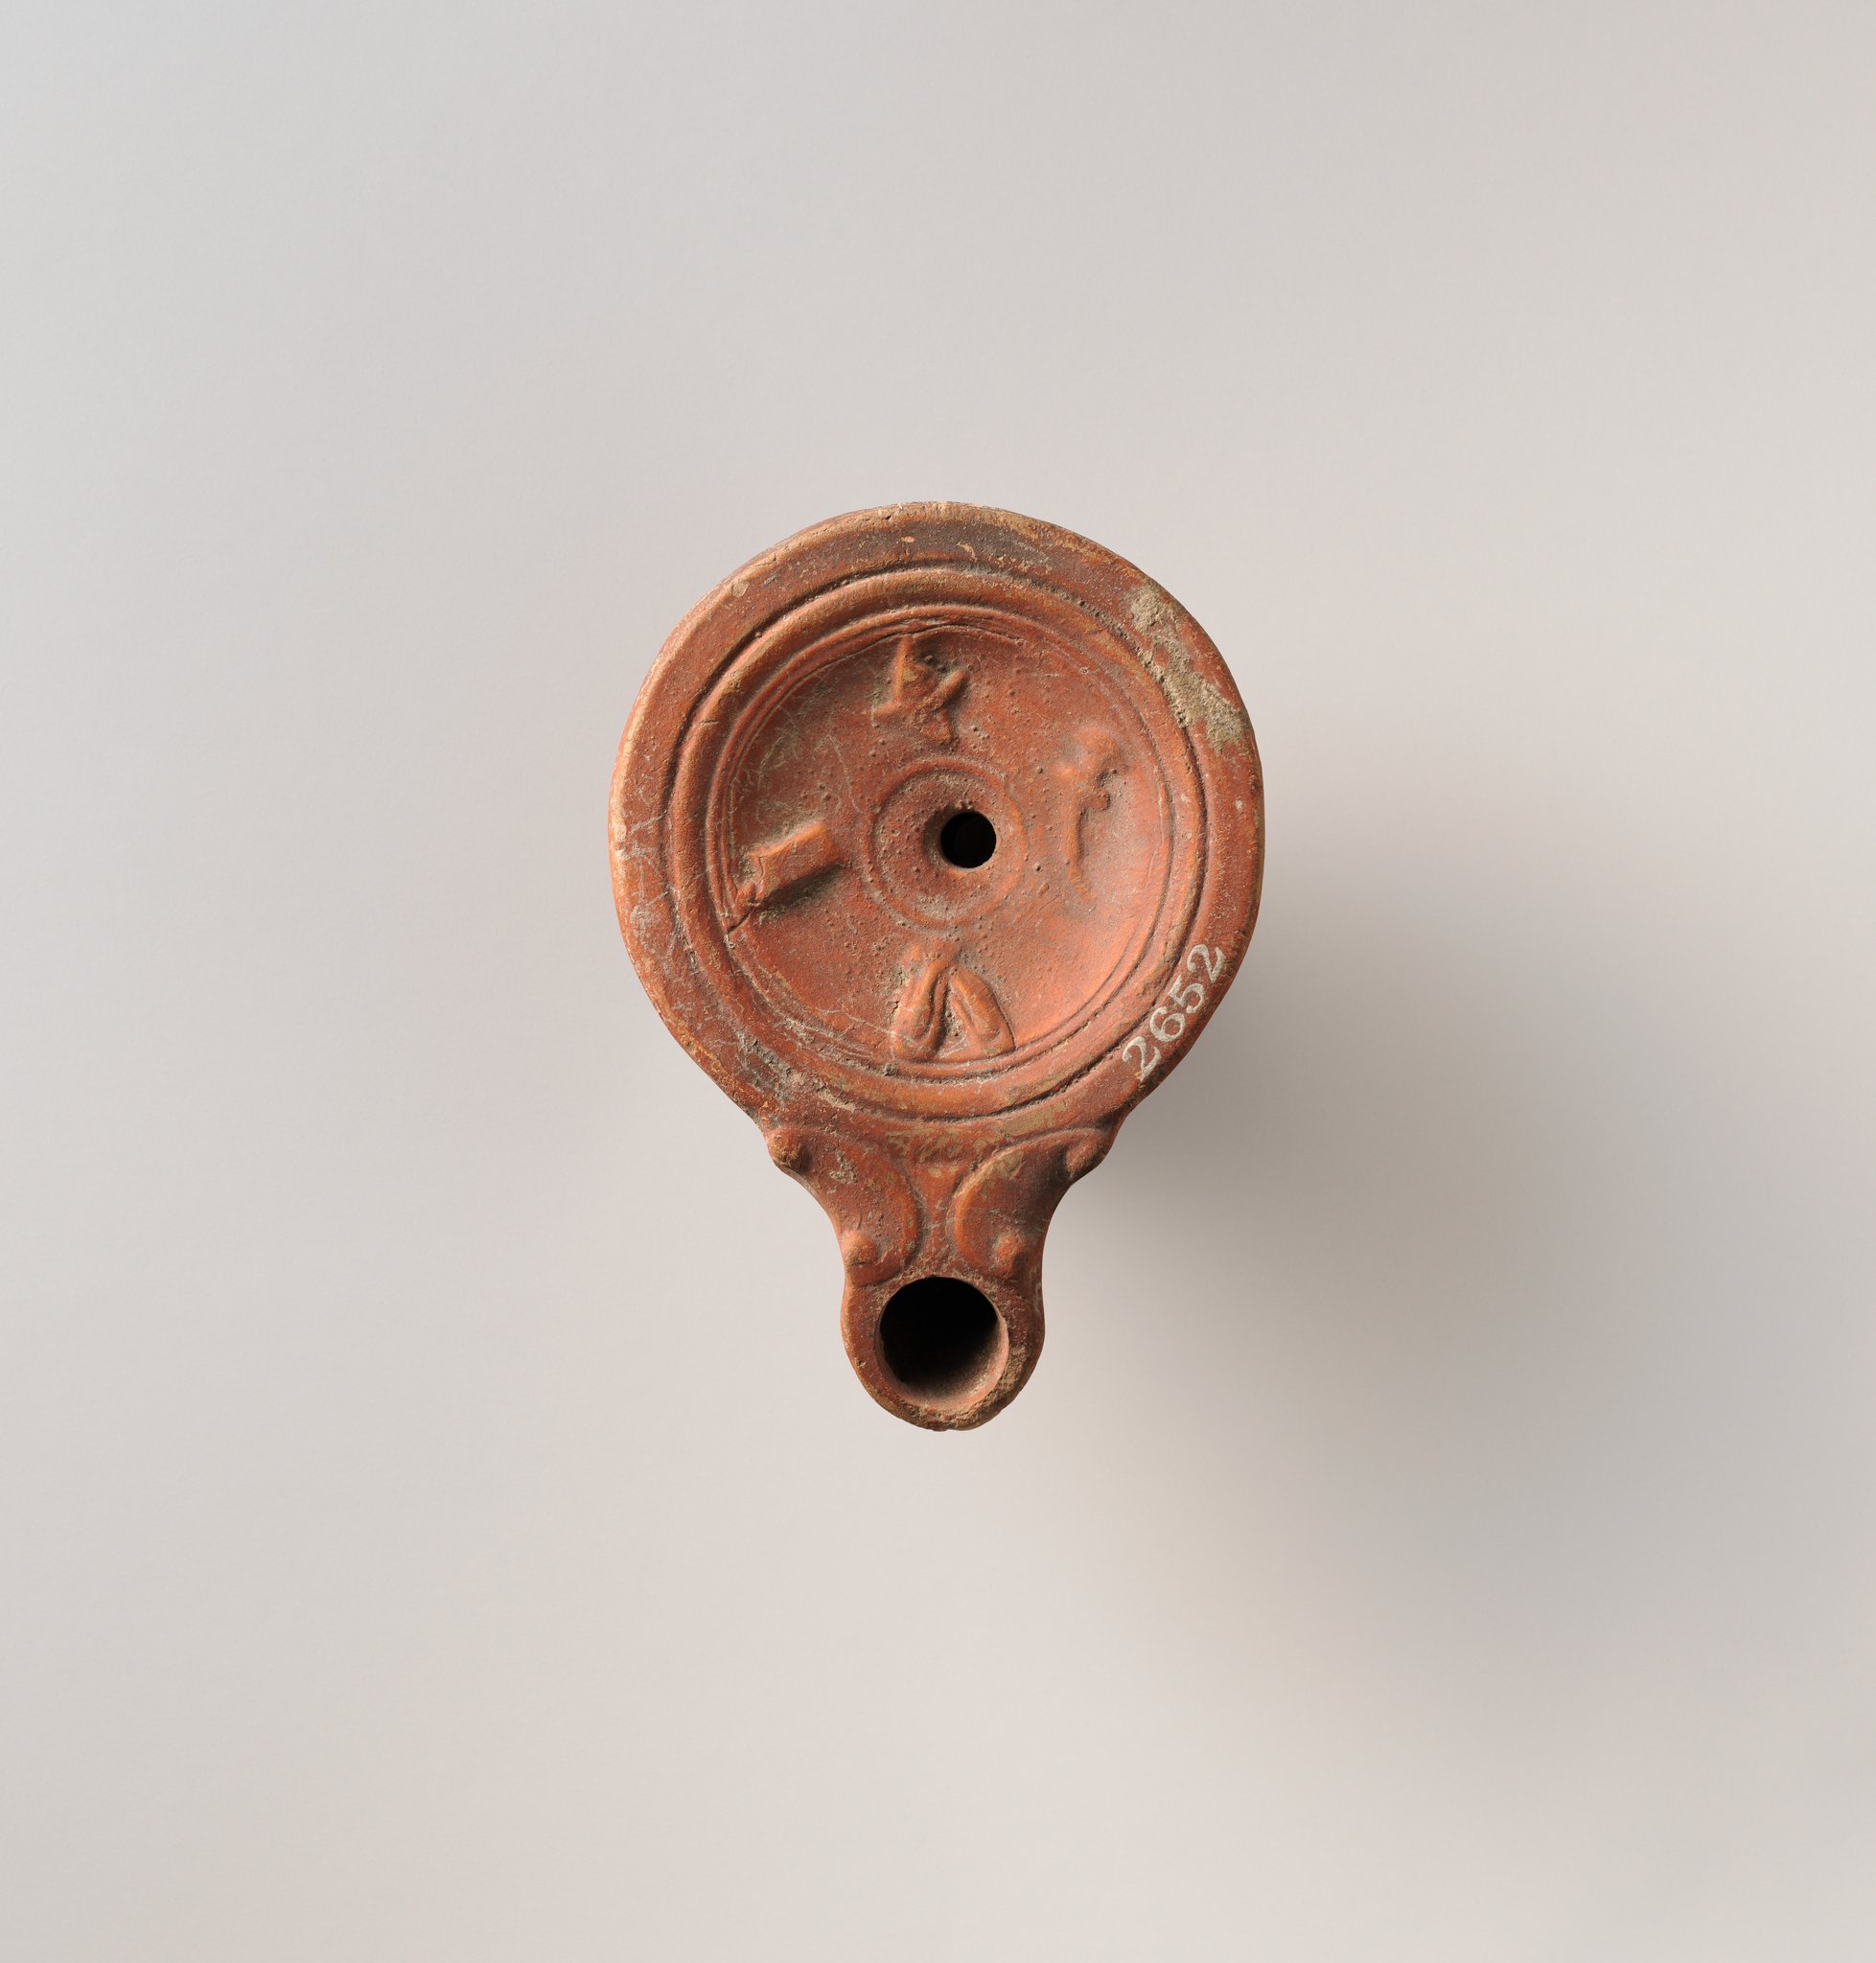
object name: lamp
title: Terracotta oil lamp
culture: roman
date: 100 BCE-100 CE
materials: terracotta